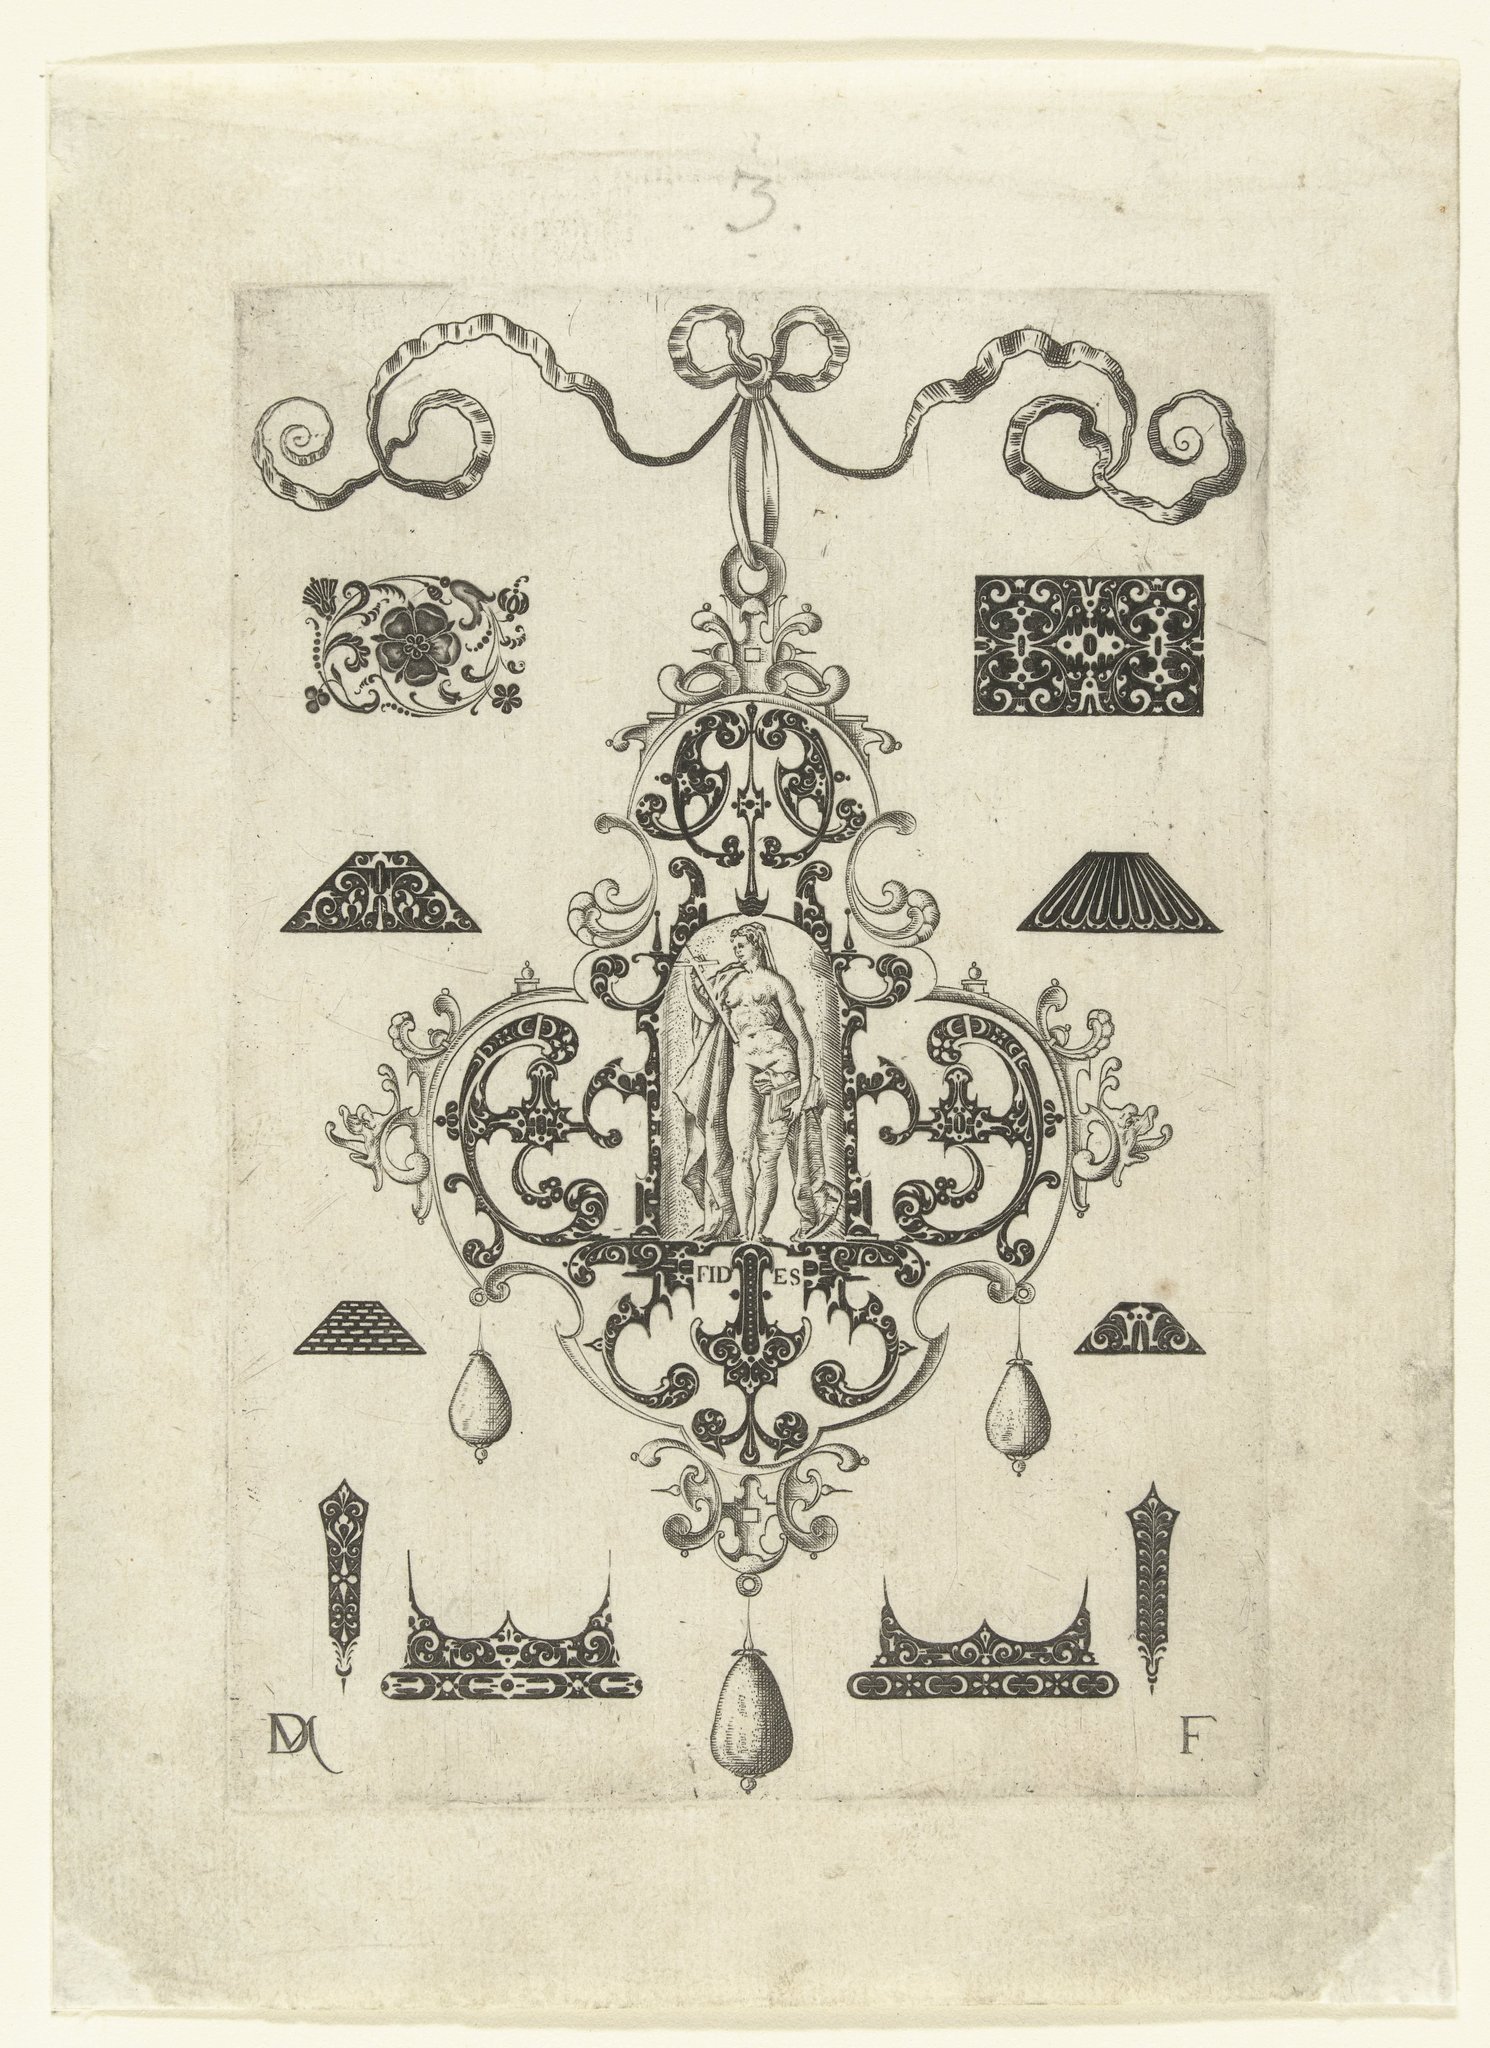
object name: ornament print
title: Hanger met Fides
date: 1593-1616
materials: paper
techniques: engraving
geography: germany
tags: faith, 'fides'; 'fede', 'fede catholica', 'fede christiana', 'fede christiana catholica' (ripa) ~ one of the three theological virtues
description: Fides in een omlijsting van krulwerk. Blad uit serie van hangers met deugden, bestaande uit een titelblad en 7 bladen. Aan elke hanger hangen drie parels. Om de hangers heen zijn kleine kostuumsieraden weergegeven.